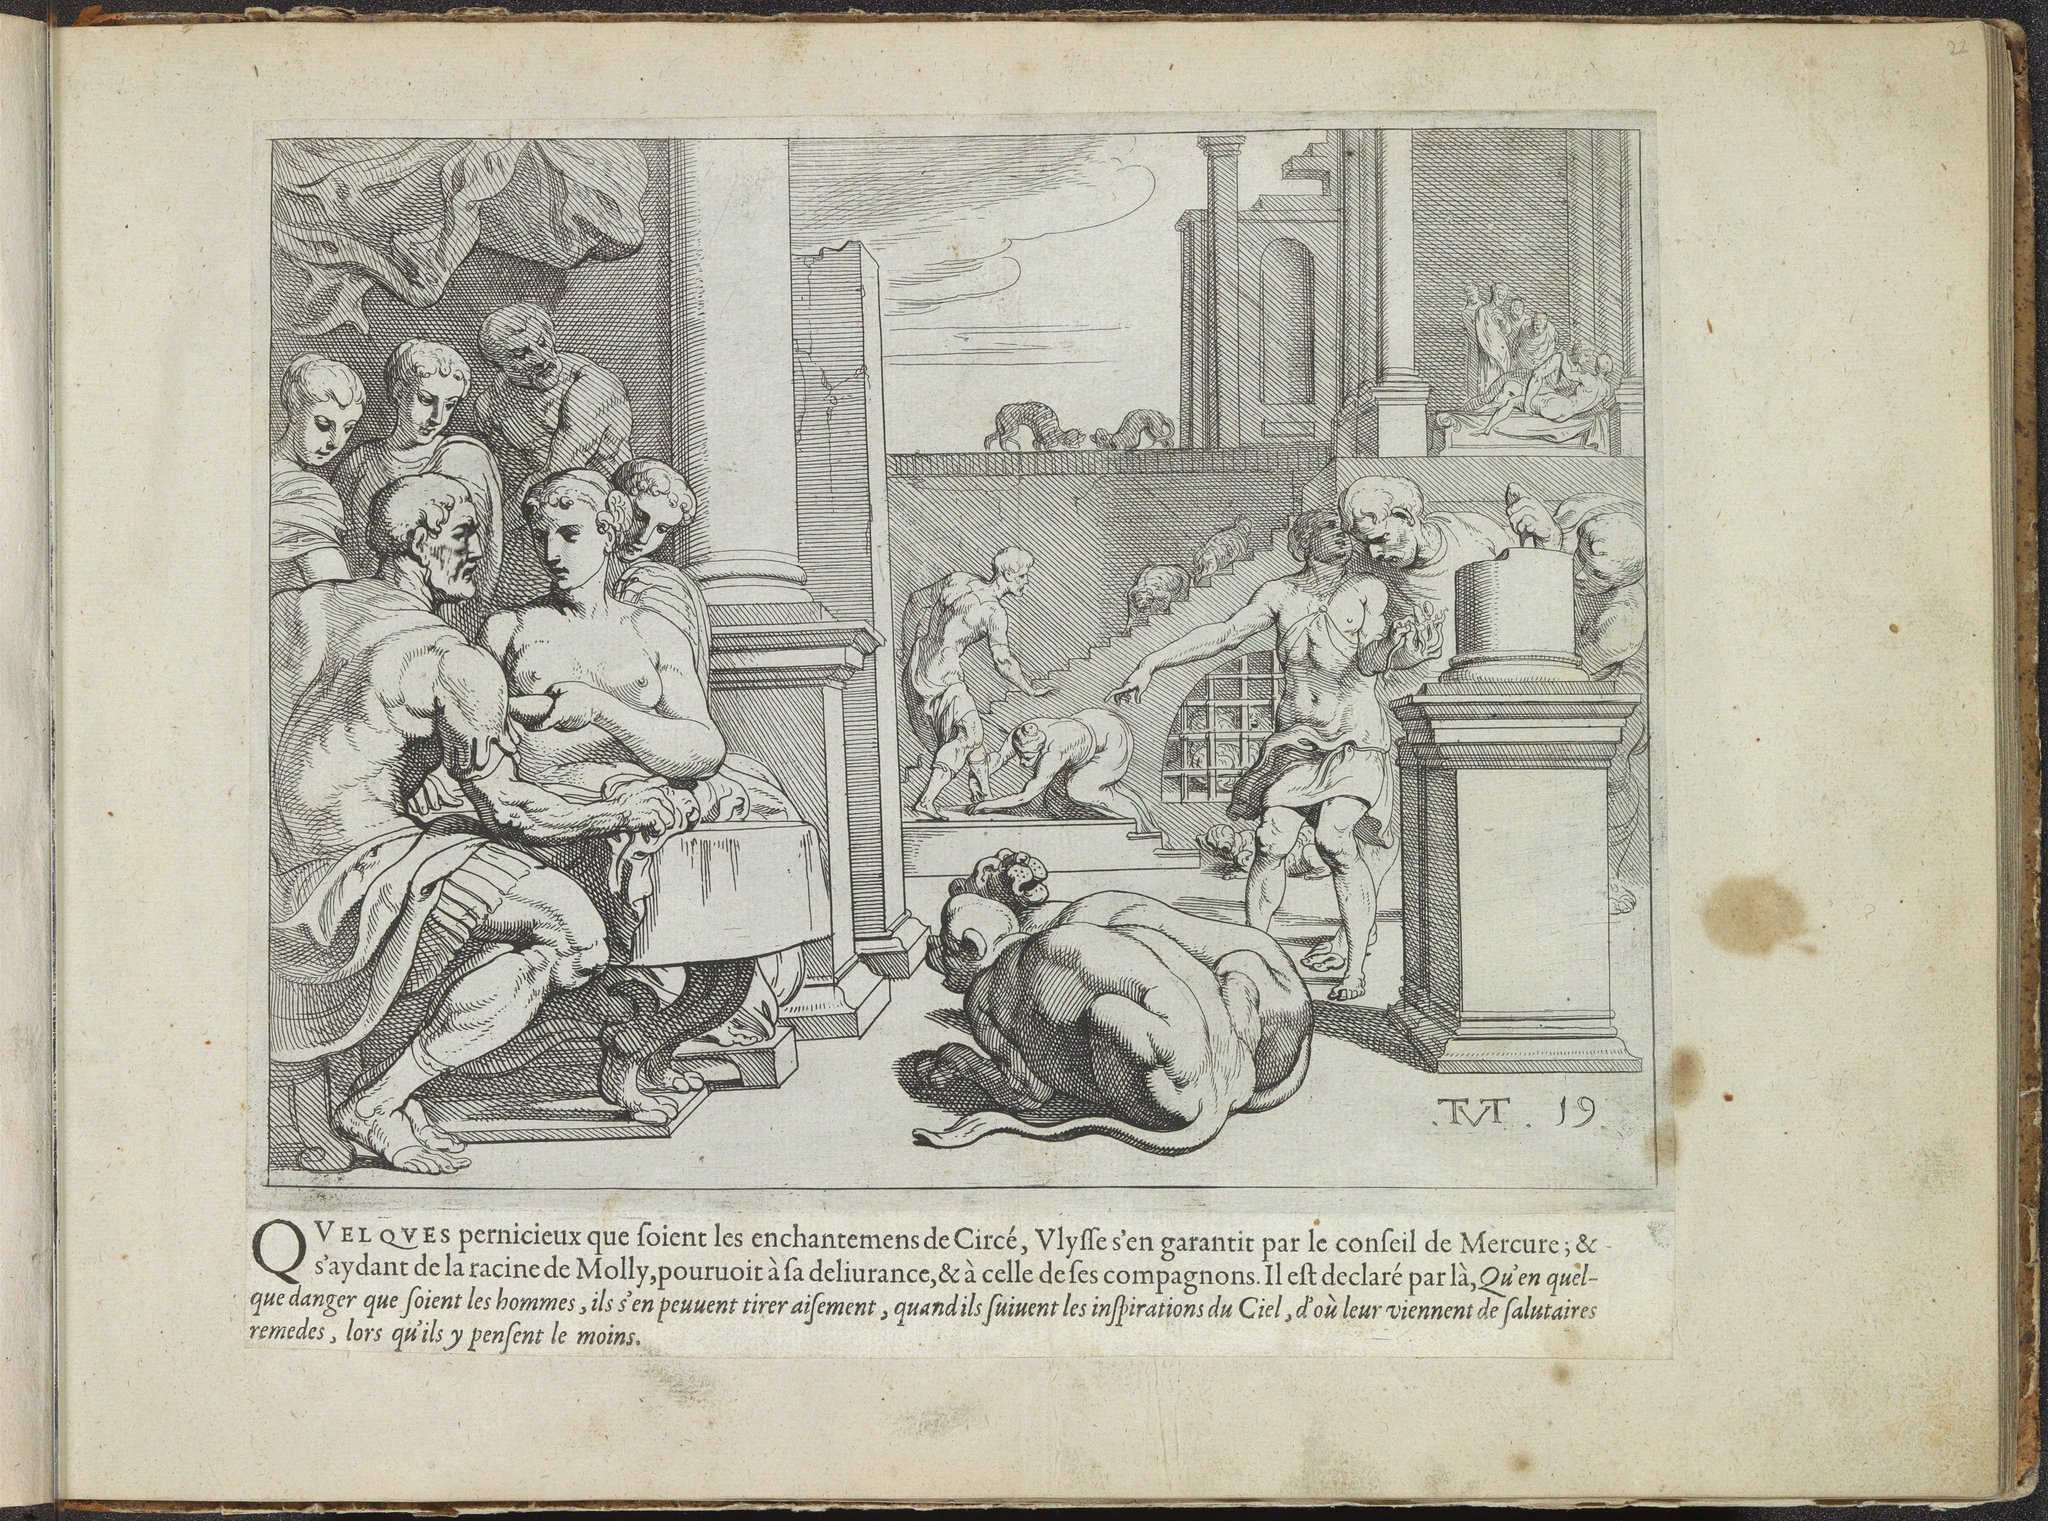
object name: print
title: Odysseus in het paleis van Circe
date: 1633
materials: paper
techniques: engraving, etching, letterpress printing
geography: paris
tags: mercury gives ulysses the magic herb 'moly', a countercharm, ulysses at the house of circe; she begs for mercy after ulysses has resisted her drugged cup, ulysses' companions are changed into all kinds of animals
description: Odysseus in het paleis van Circe. Rechts biedt Mercurius aan Odysseus een kruid aan dat werkt als tegengif tegen de toverdrank van Circe. Odysseus eet het op en gaat naar Circe. Daar zijn de mannen van Odysseus veranderd in dieren en zwijnen omdat ze van de toverdrank hebben gedronken. Links op de voorgrond geeft Circe de toverdrank aan Odysseus. De drank heeft geen effect op hem en hij vraagt haar om zijn mannen hun menselijke gestalte terug te geven. Circe willigt dit verzoek in, maar vraagt Odysseus om eerst met haar naar bed te gaan. Dit gebeurt in de rechter bovenhoek. De prent maakt deel uit van een album.